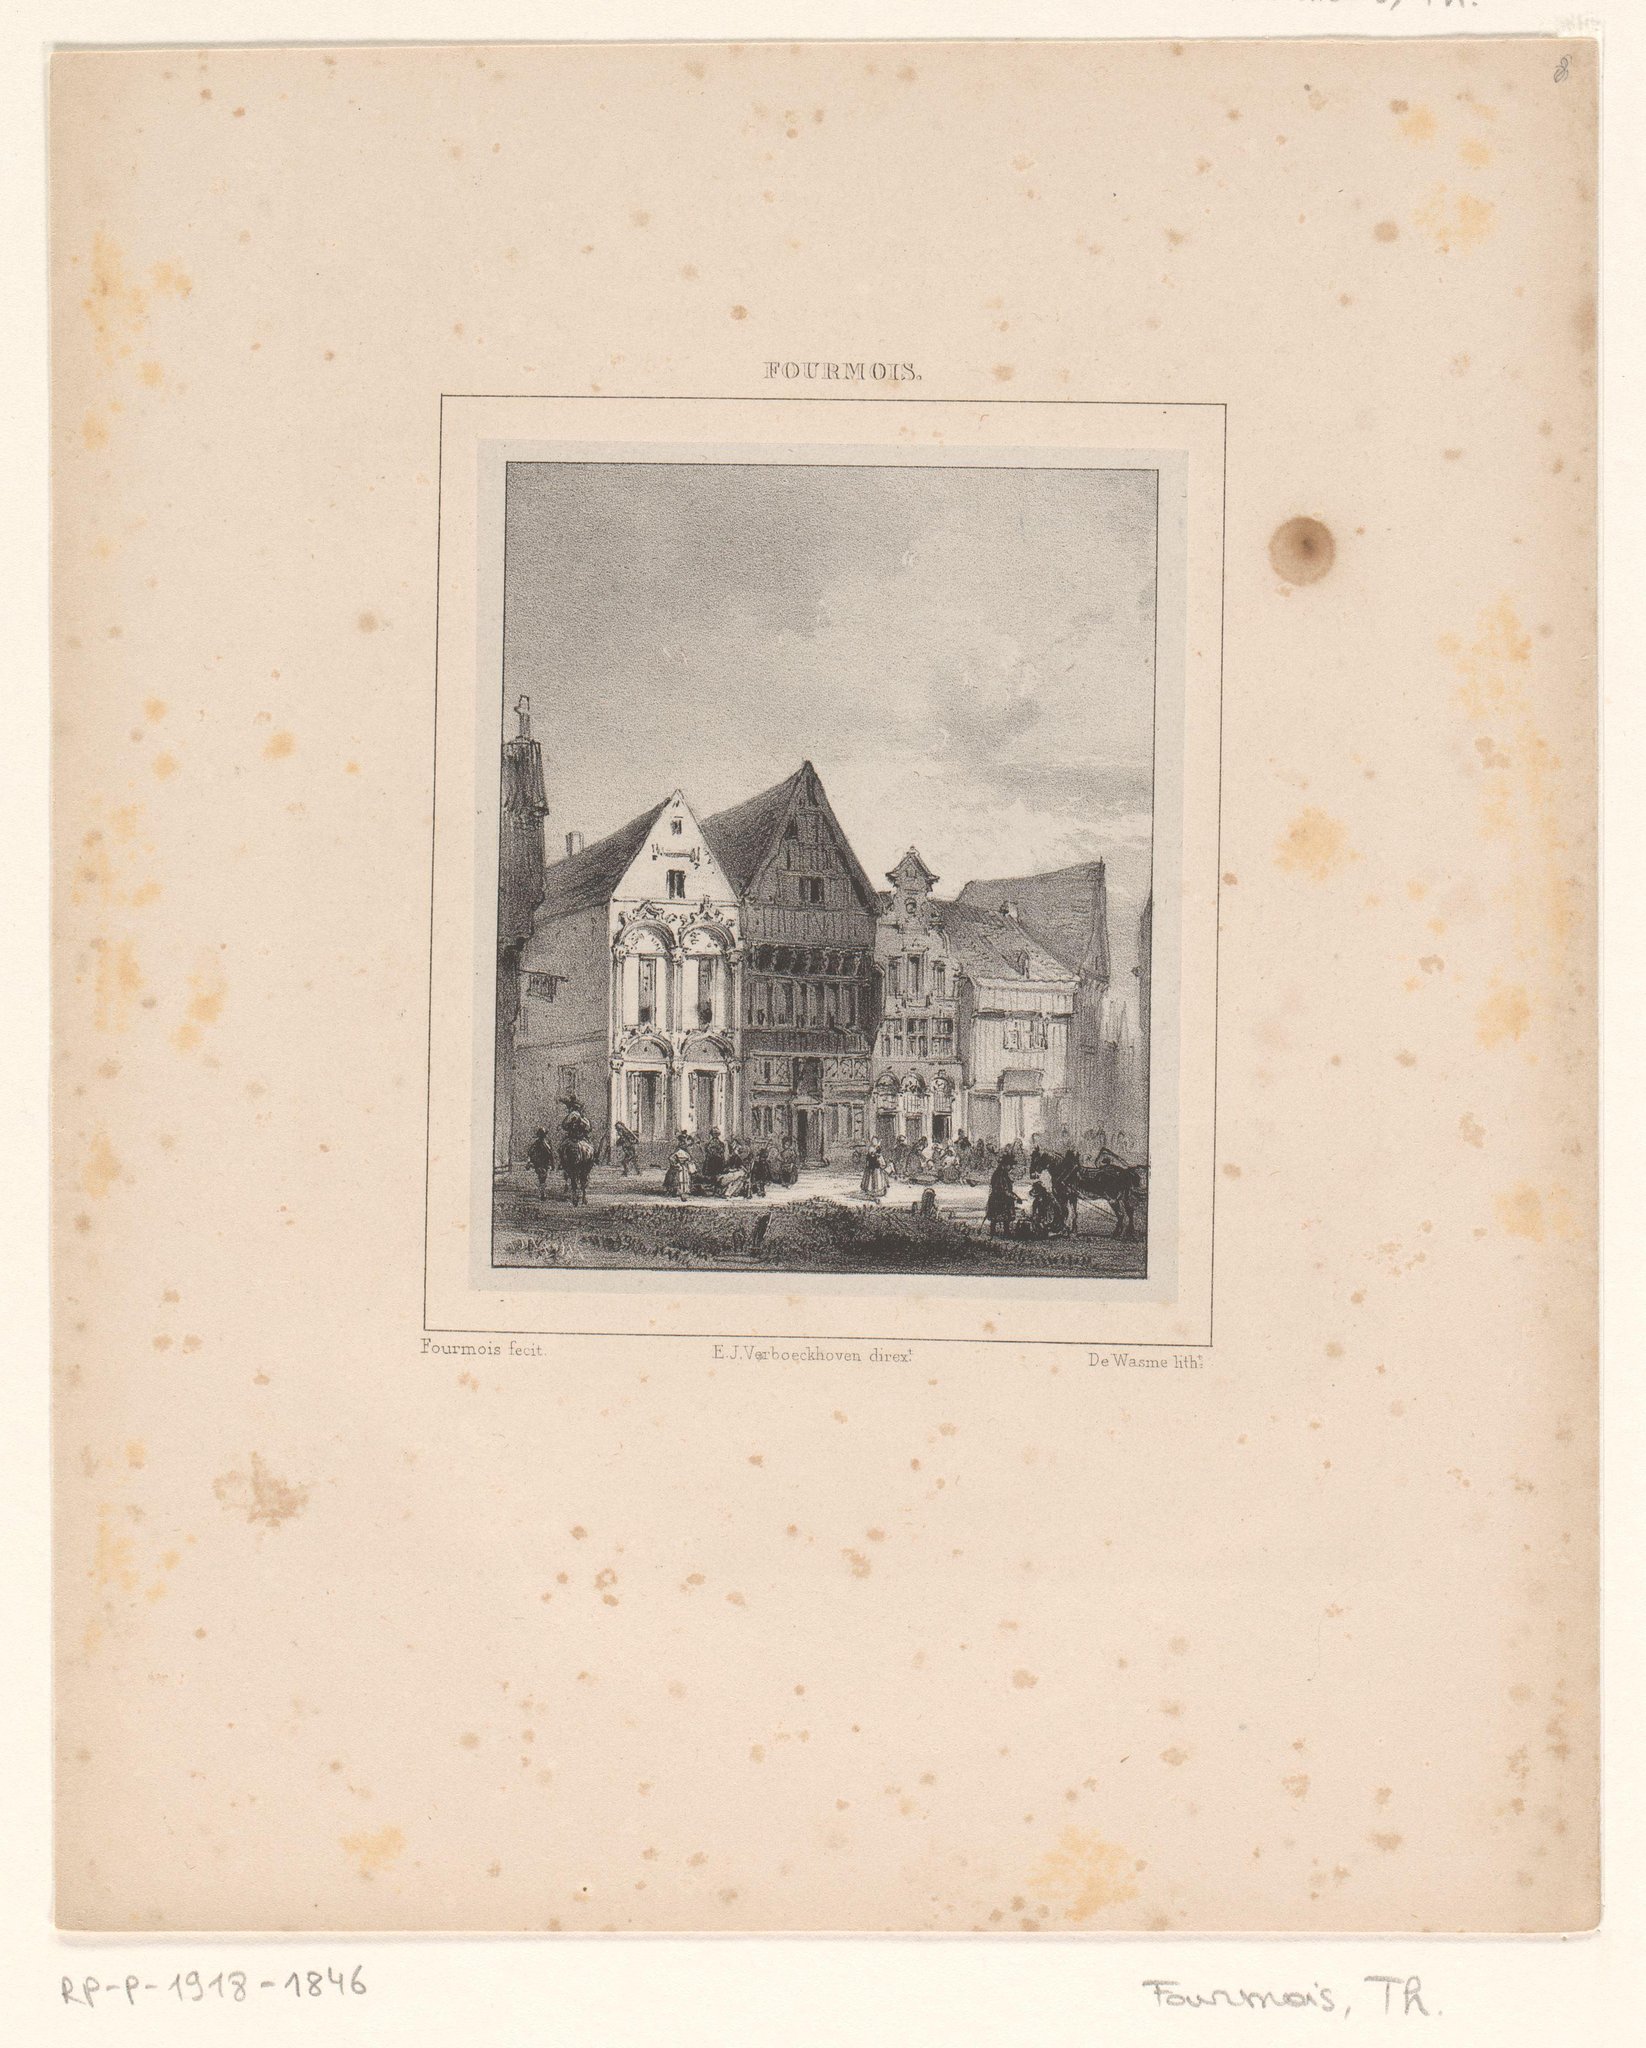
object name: print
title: Fourmois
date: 1825-1827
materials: paper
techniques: lithograph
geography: brussels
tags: city-view in general; 'veduta' (+ city(-scape) with figures, staffage)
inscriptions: collector's mark: Lugt 2233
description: Prent maakt waarschijnlijk deel uit van een serie met taferelen naar andere kunstenaars. Over deze serie is verder niets bekend.